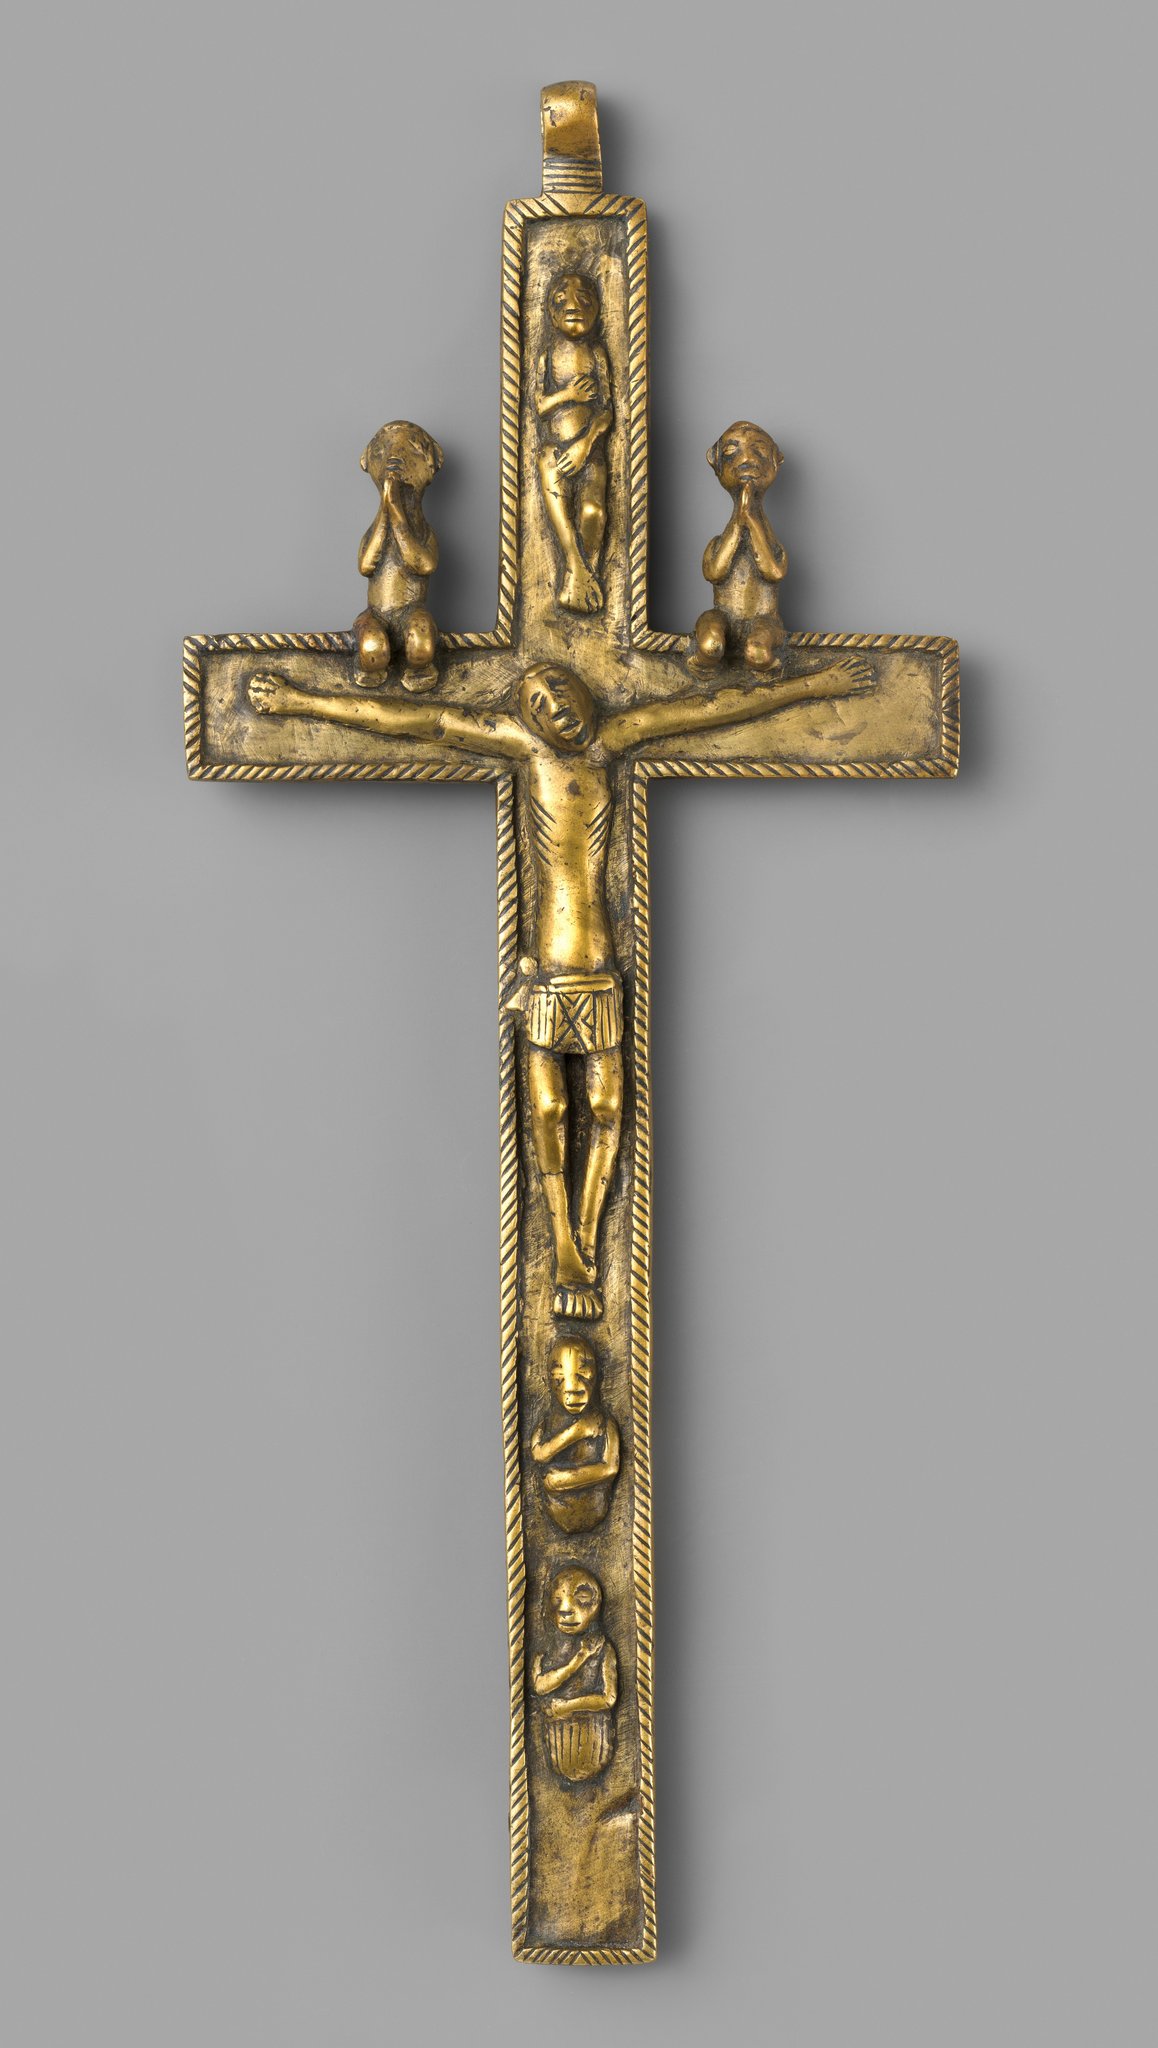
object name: crucifix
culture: kongo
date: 1601-1800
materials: brass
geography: angola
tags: christ,cross,crucifixion